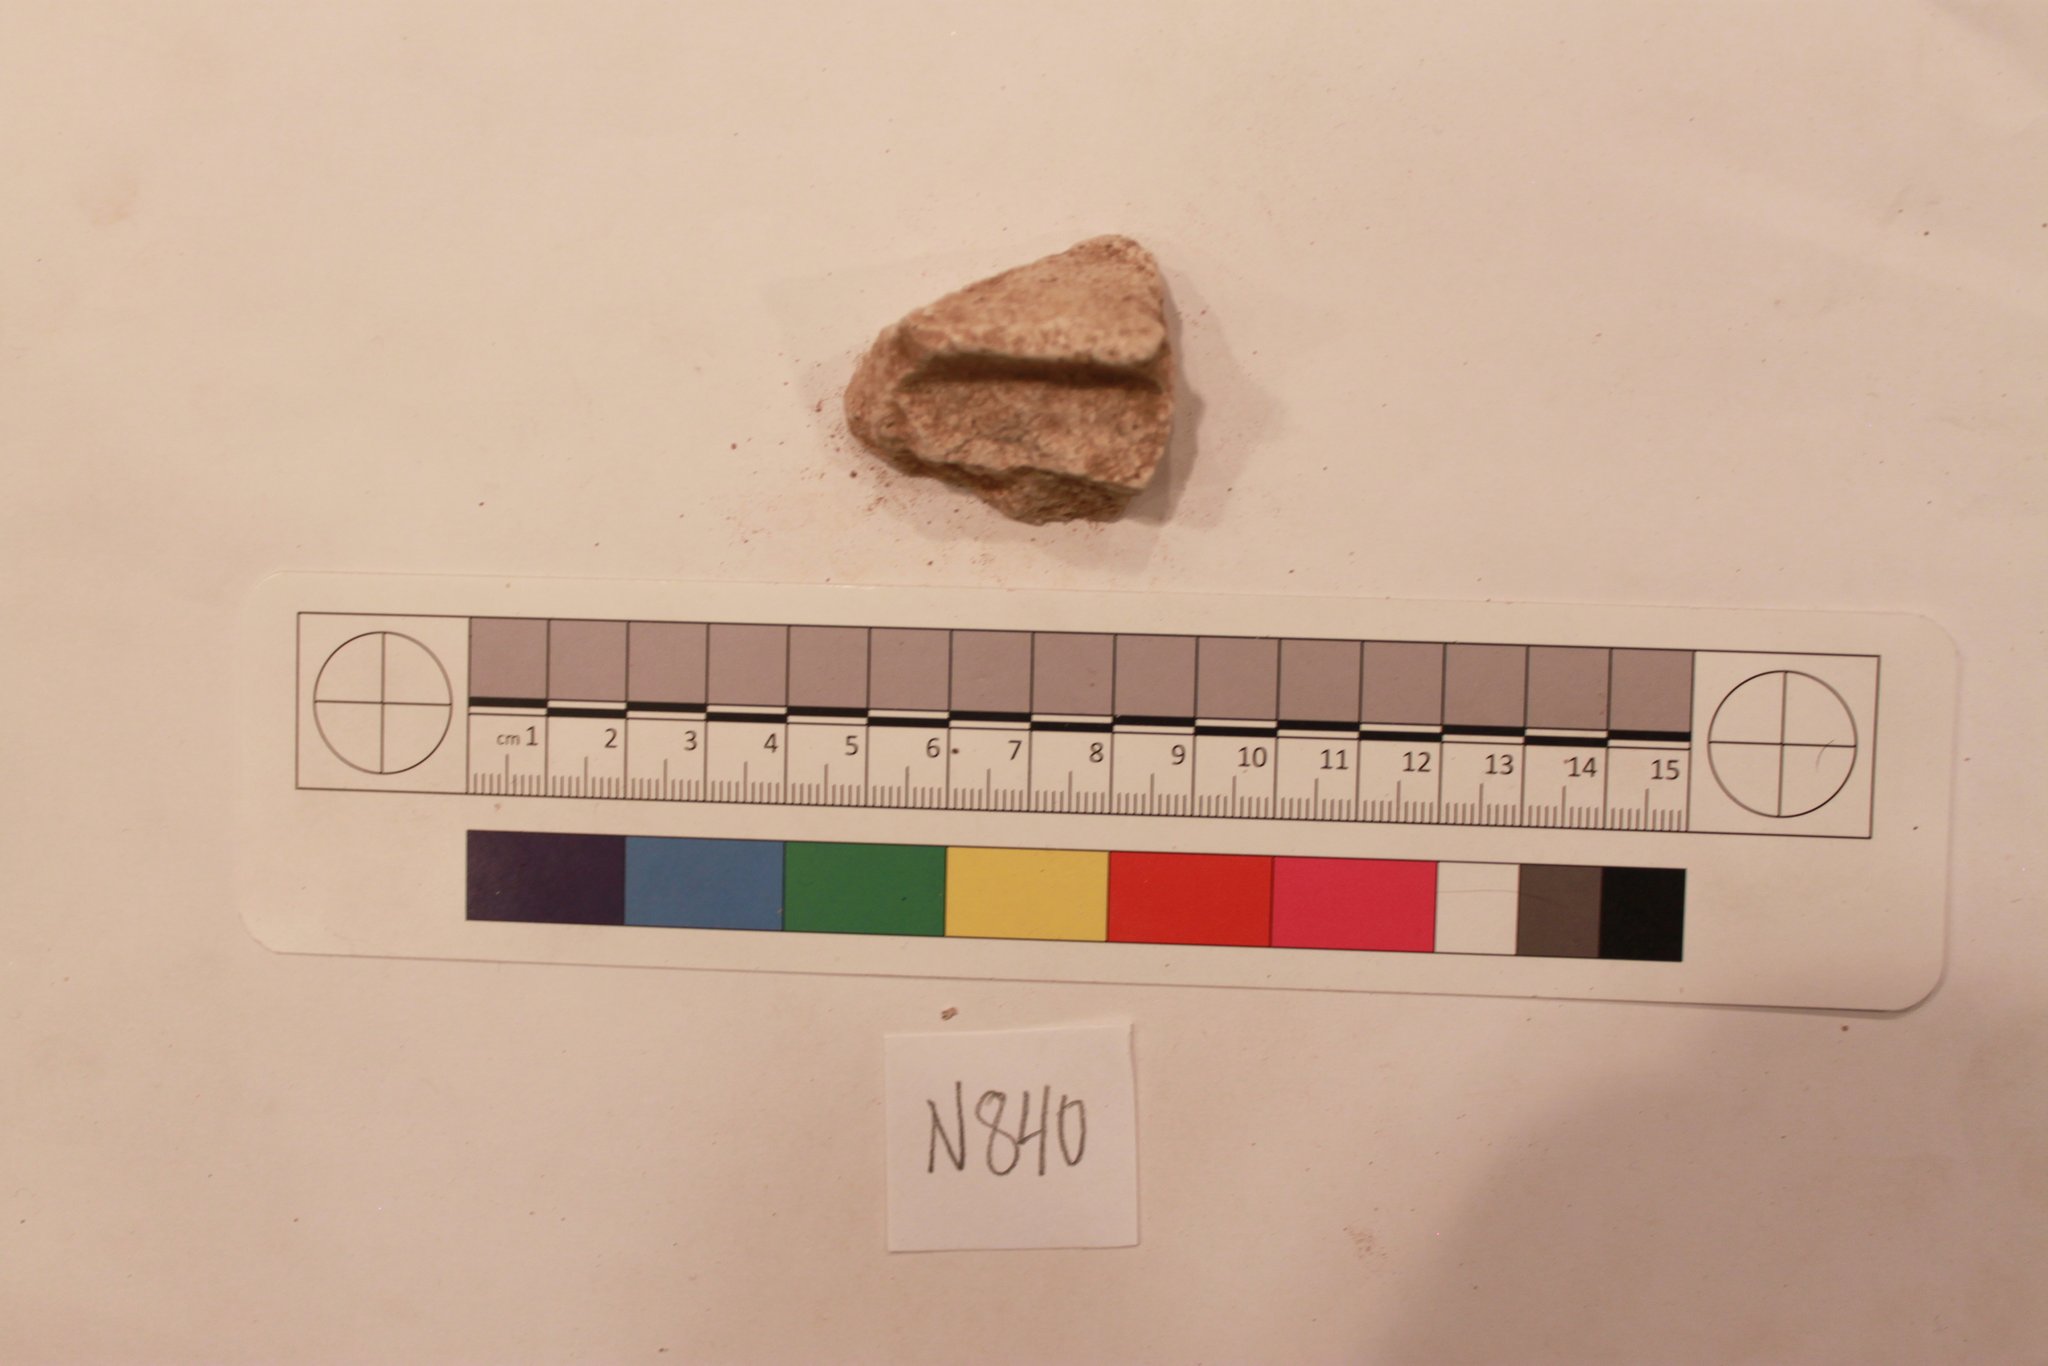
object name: fragment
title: Stucco Fragment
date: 701-1200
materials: plaster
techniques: carving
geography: iran